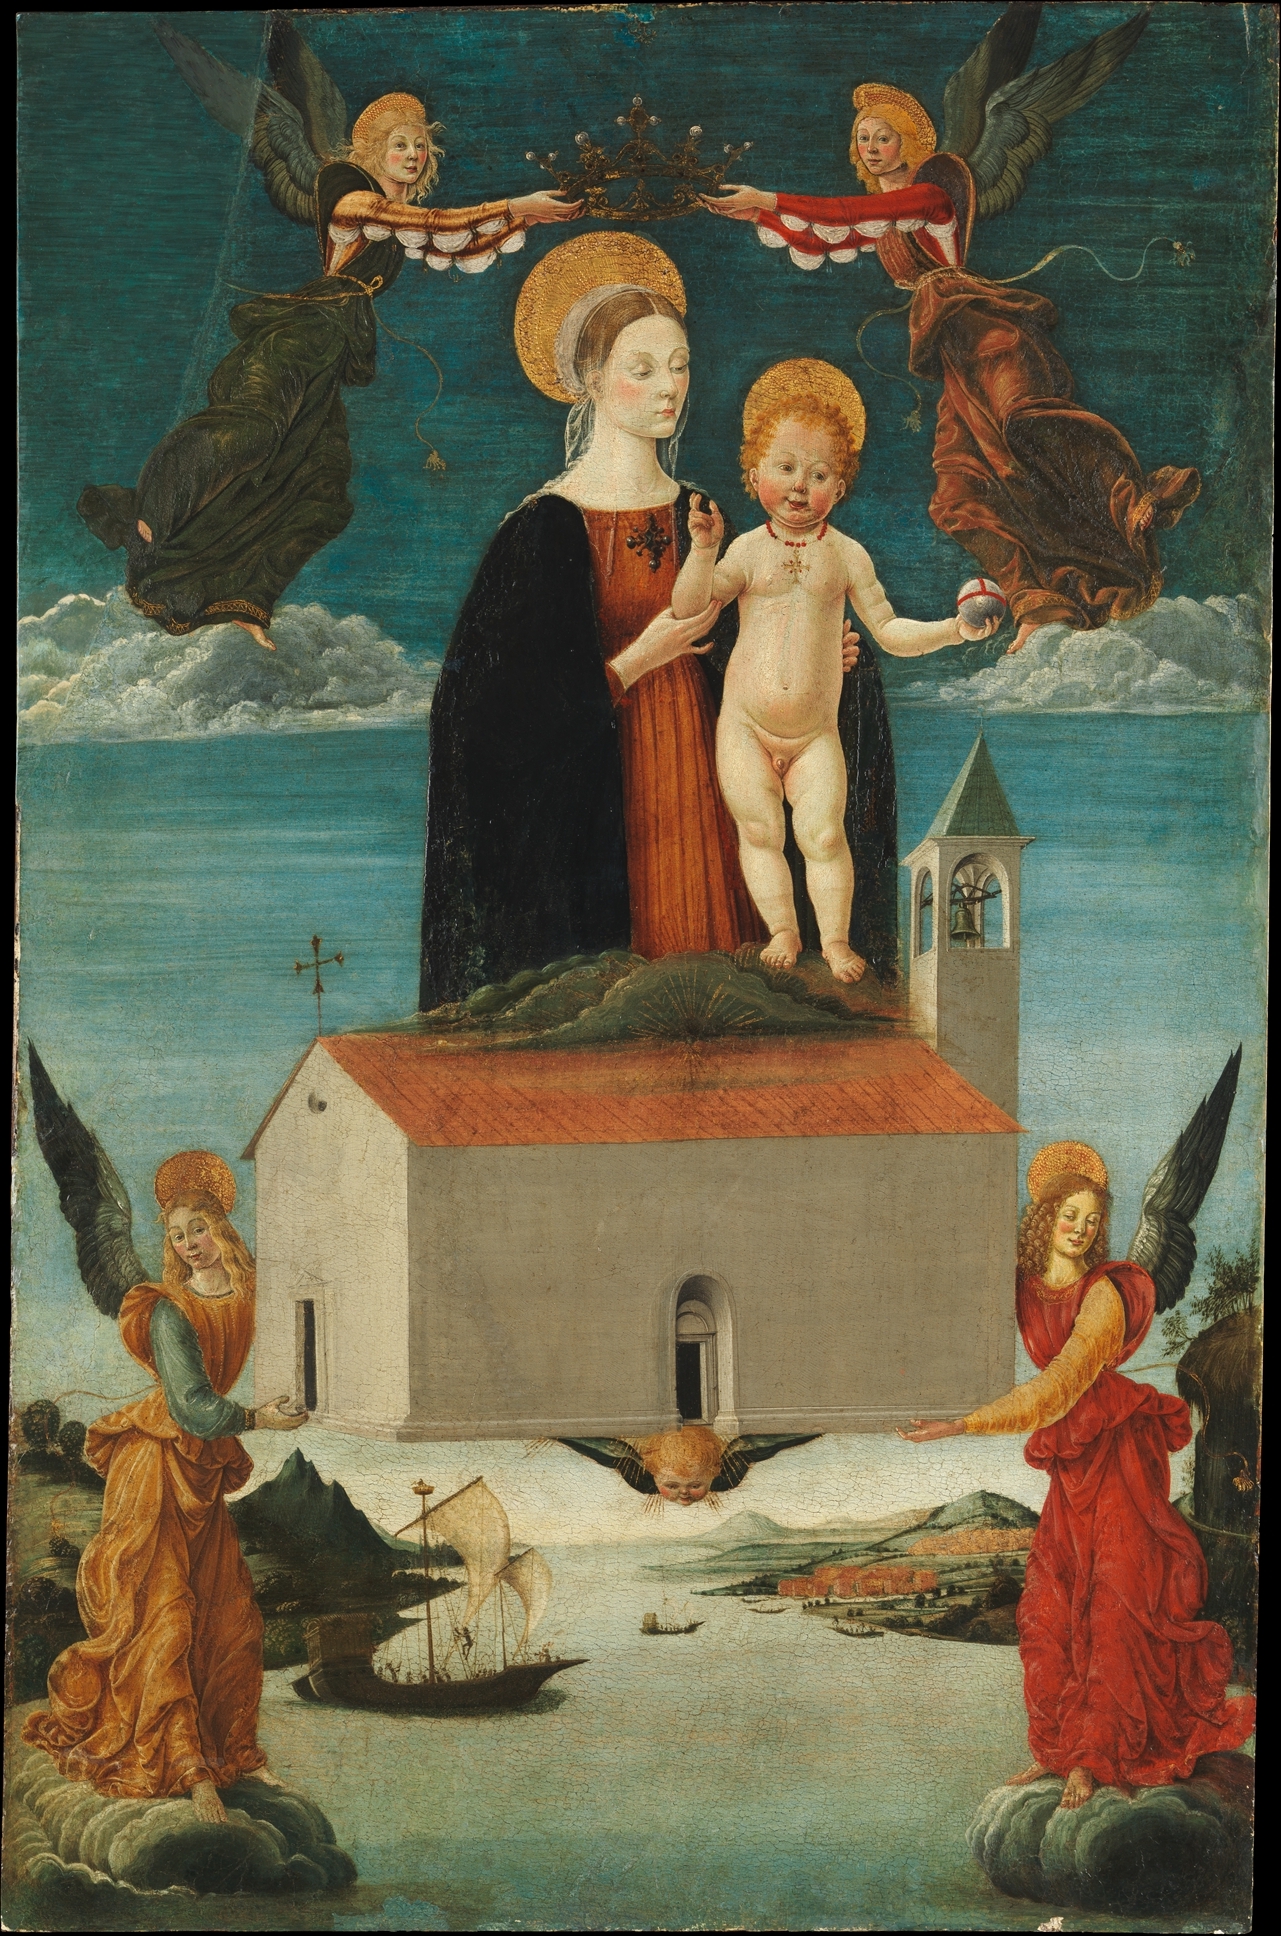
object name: painting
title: The Translation of the Holy House of Loreto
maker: saturnino gatti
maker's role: artist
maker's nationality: italian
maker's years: 1463-1518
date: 1490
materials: gold, paint, wood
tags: angels,madonna and child,ships